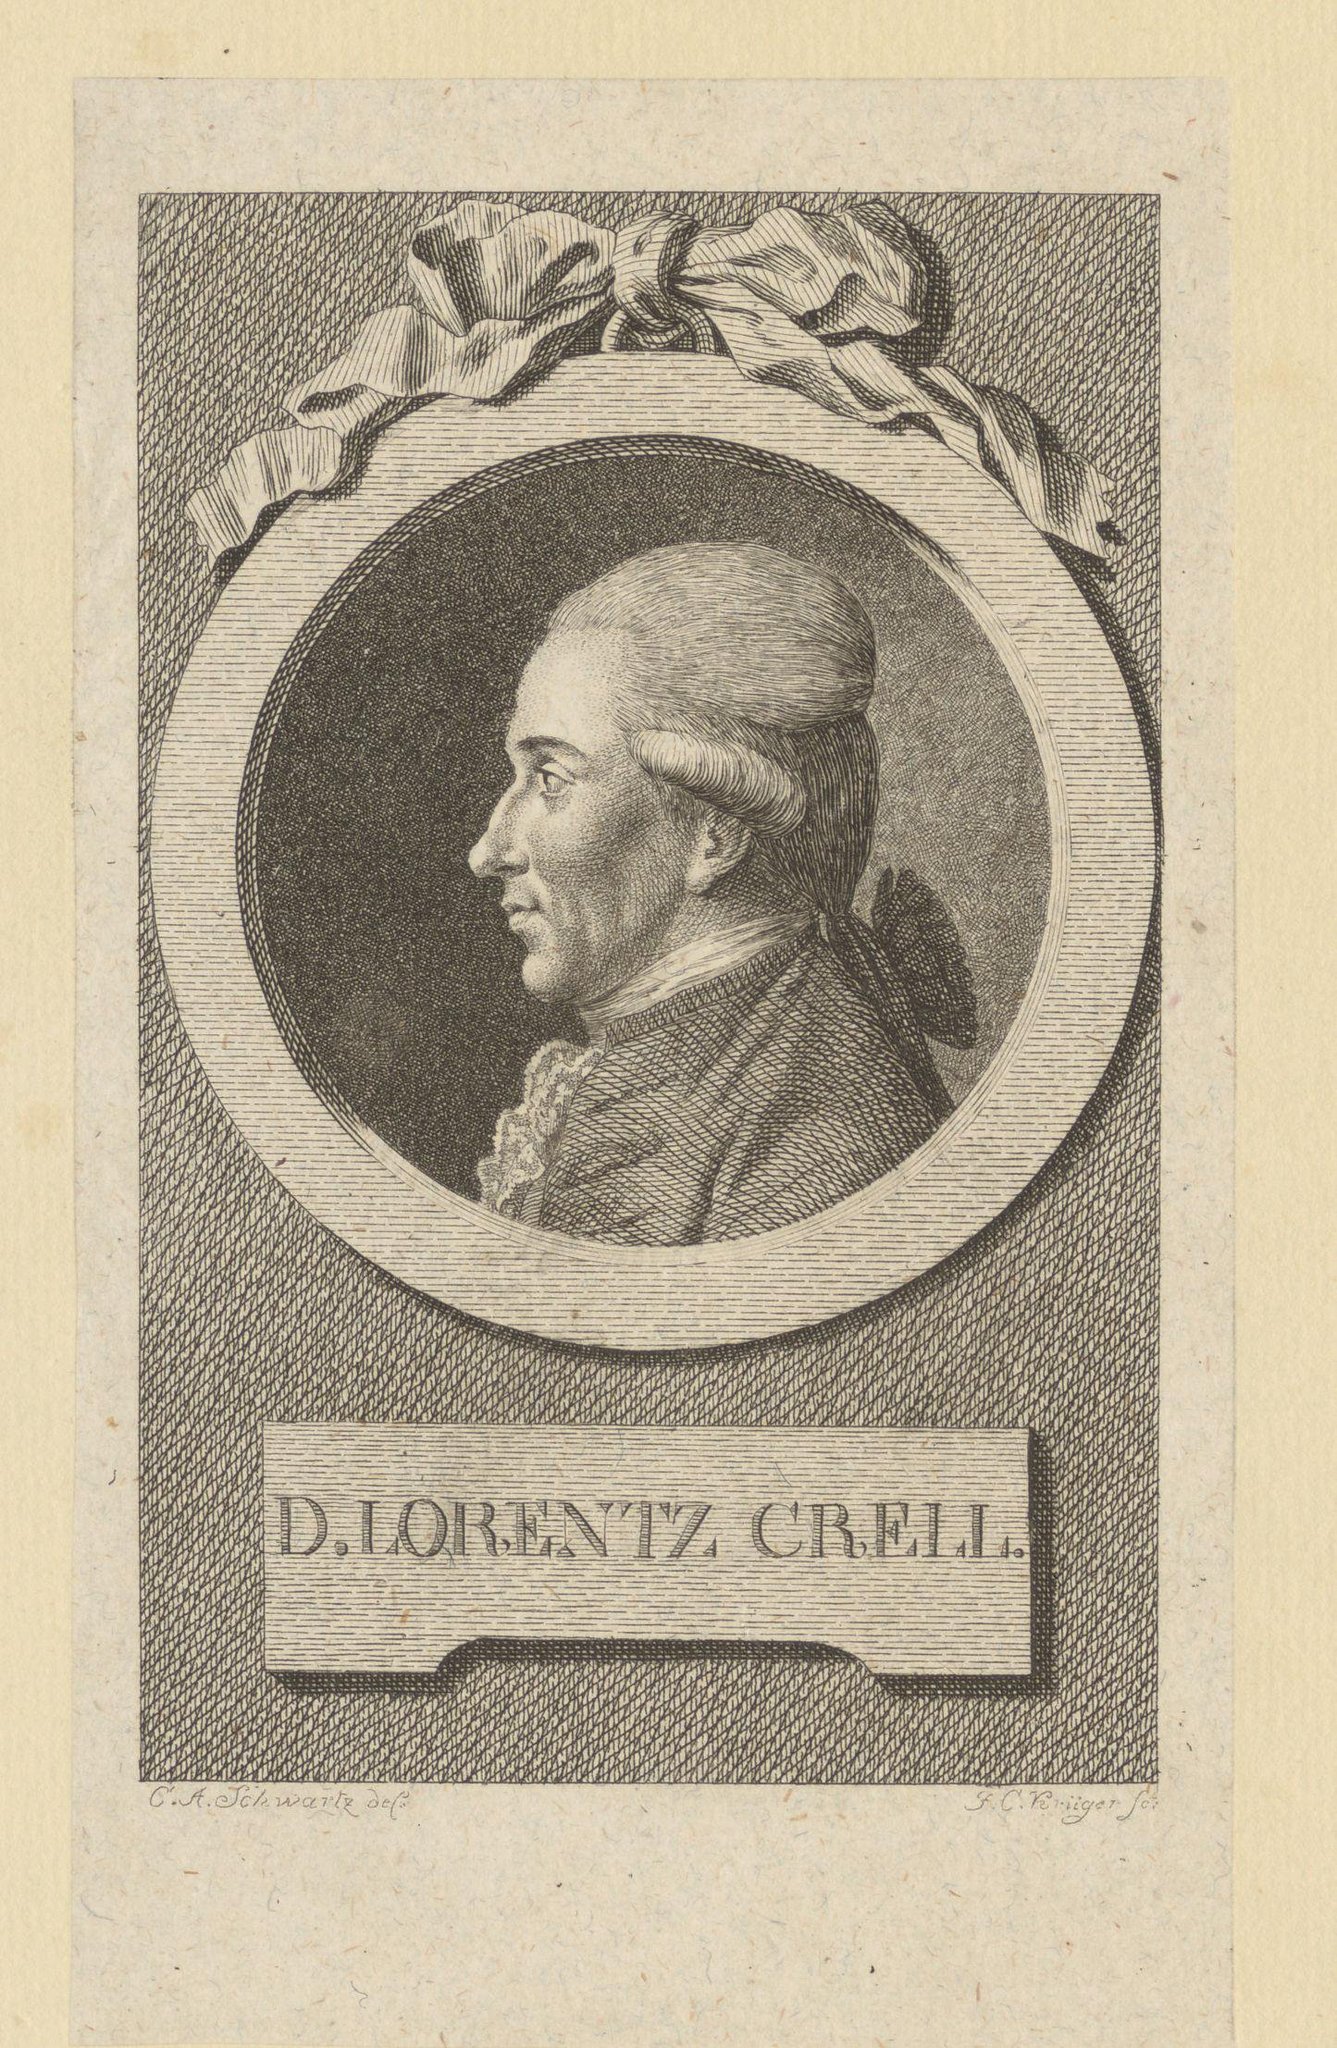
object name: print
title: Portret van Lorenz Crell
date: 1766-1791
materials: paper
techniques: engraving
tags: chemistry (+ portrait of scholar, scientist), further education (+ portrait of teacher, professor), historical persons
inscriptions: collector's mark: Lugt 2228